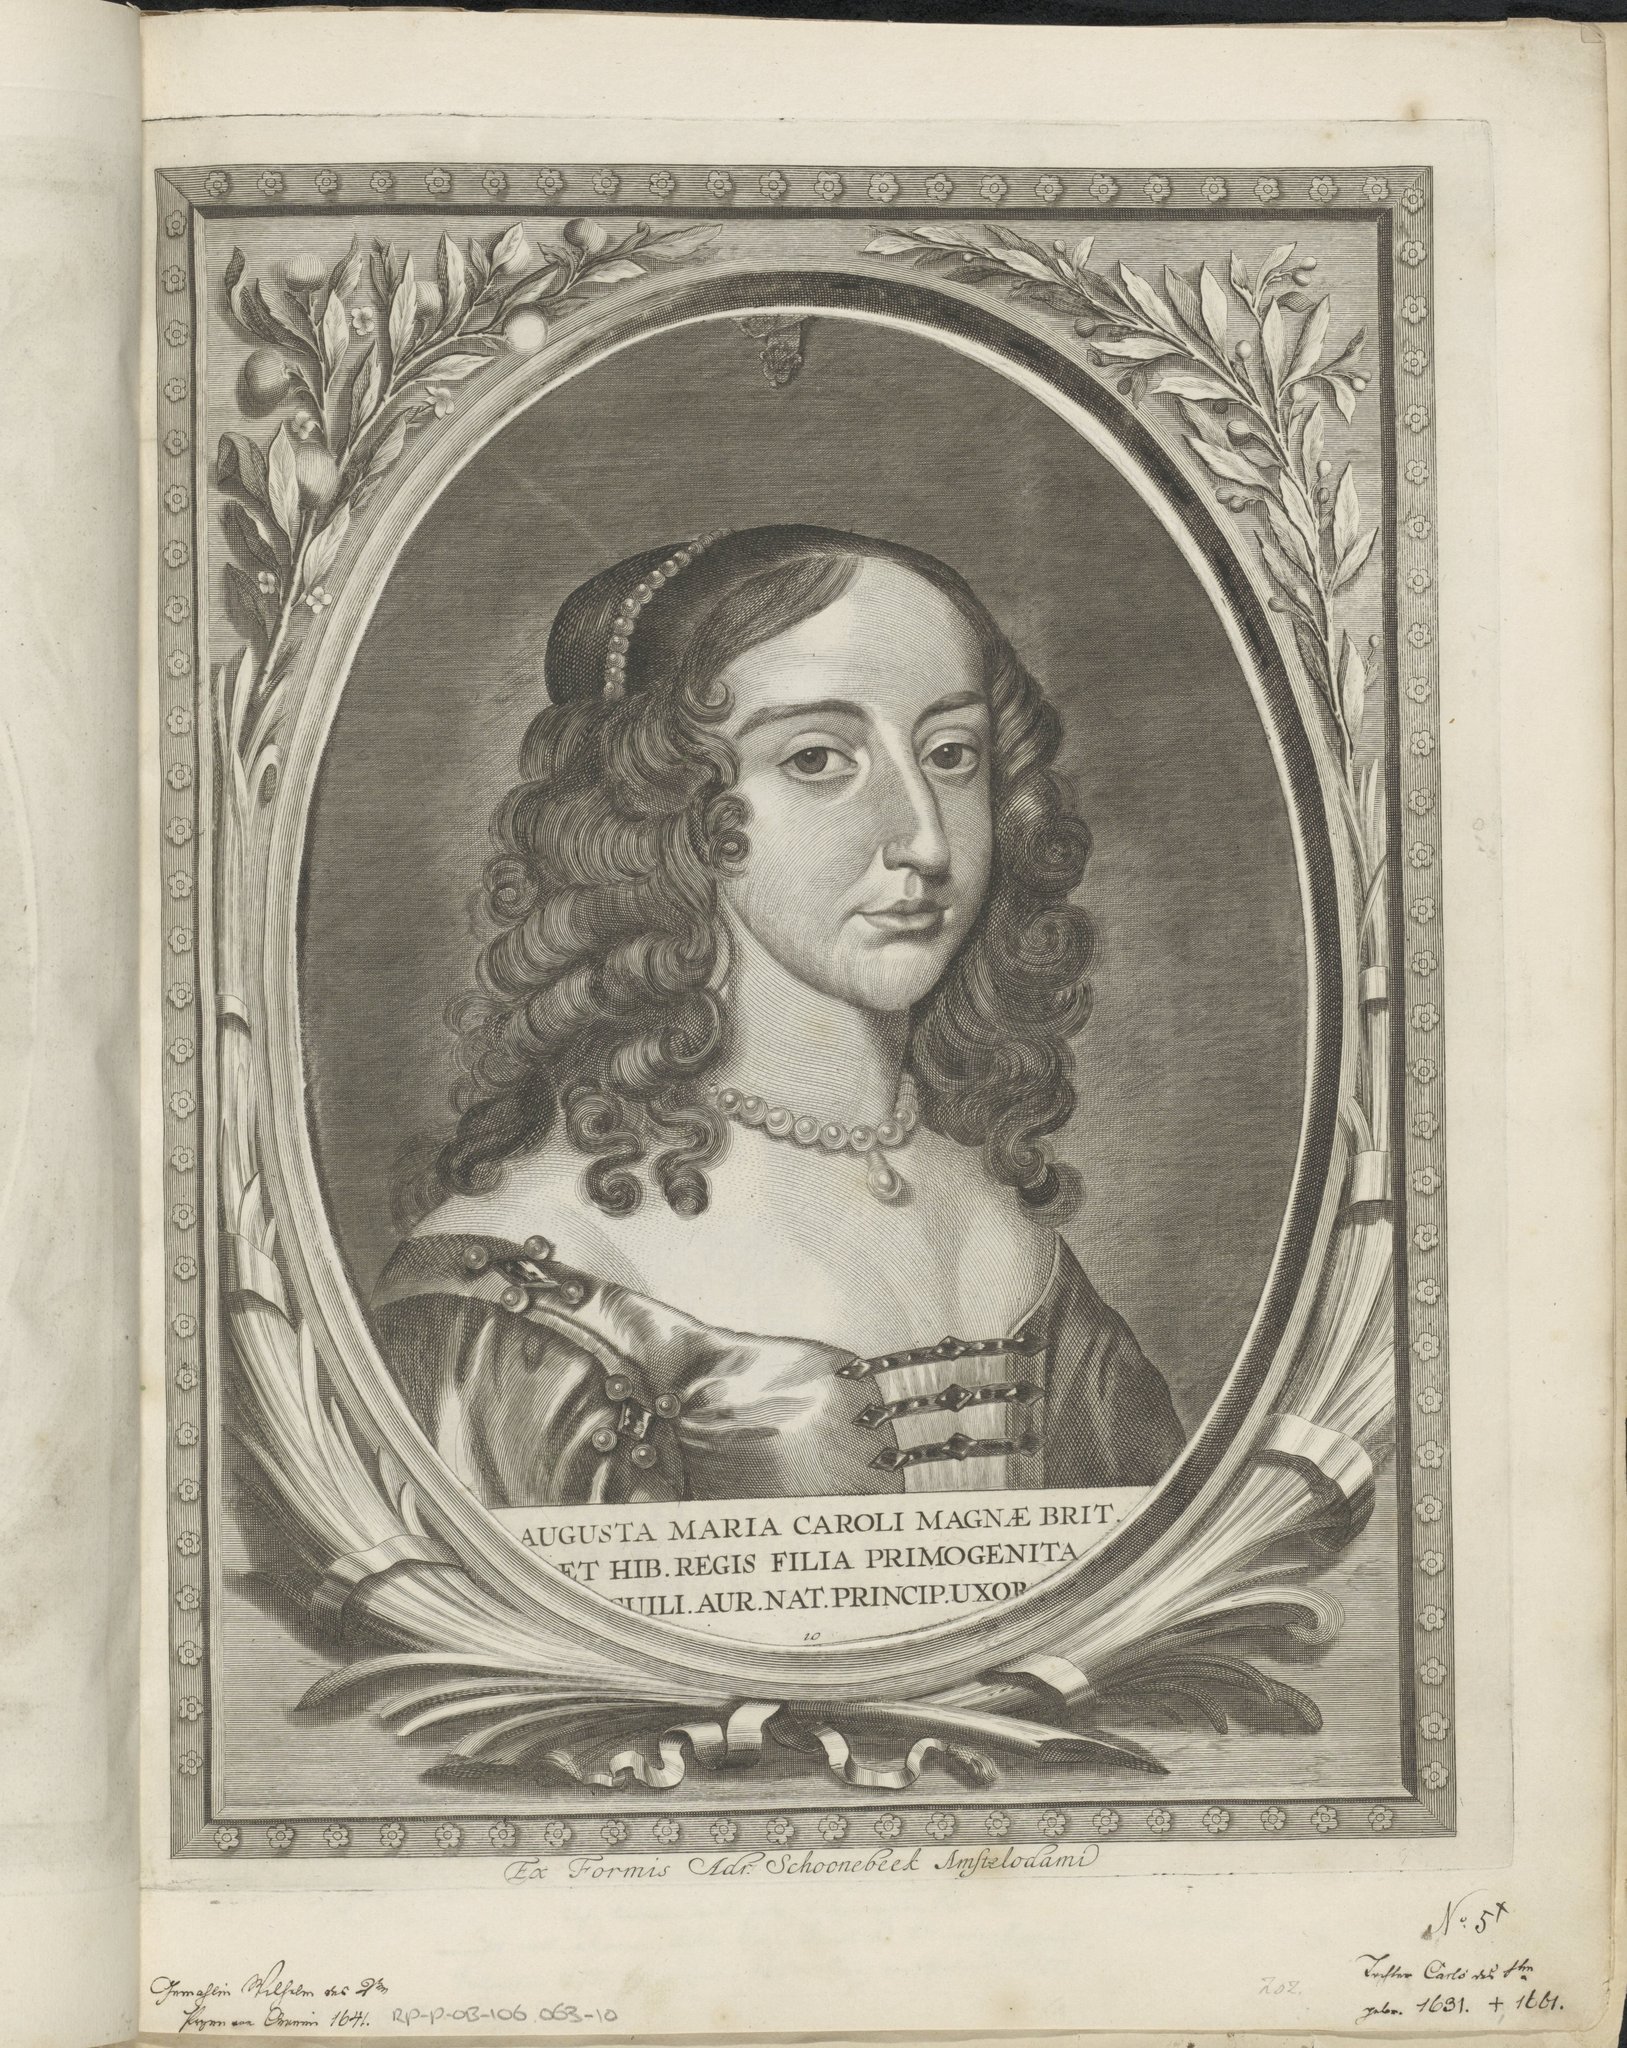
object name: print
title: Comites Nassoviae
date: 1689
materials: paper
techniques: engraving, etching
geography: low countries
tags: mary henrietta stuart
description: Portret van Maria Henrietta. In een kader haar naam en titels. Geheel in een afzonderlijk gegraveerde ovale omlijsting met takken en linten.